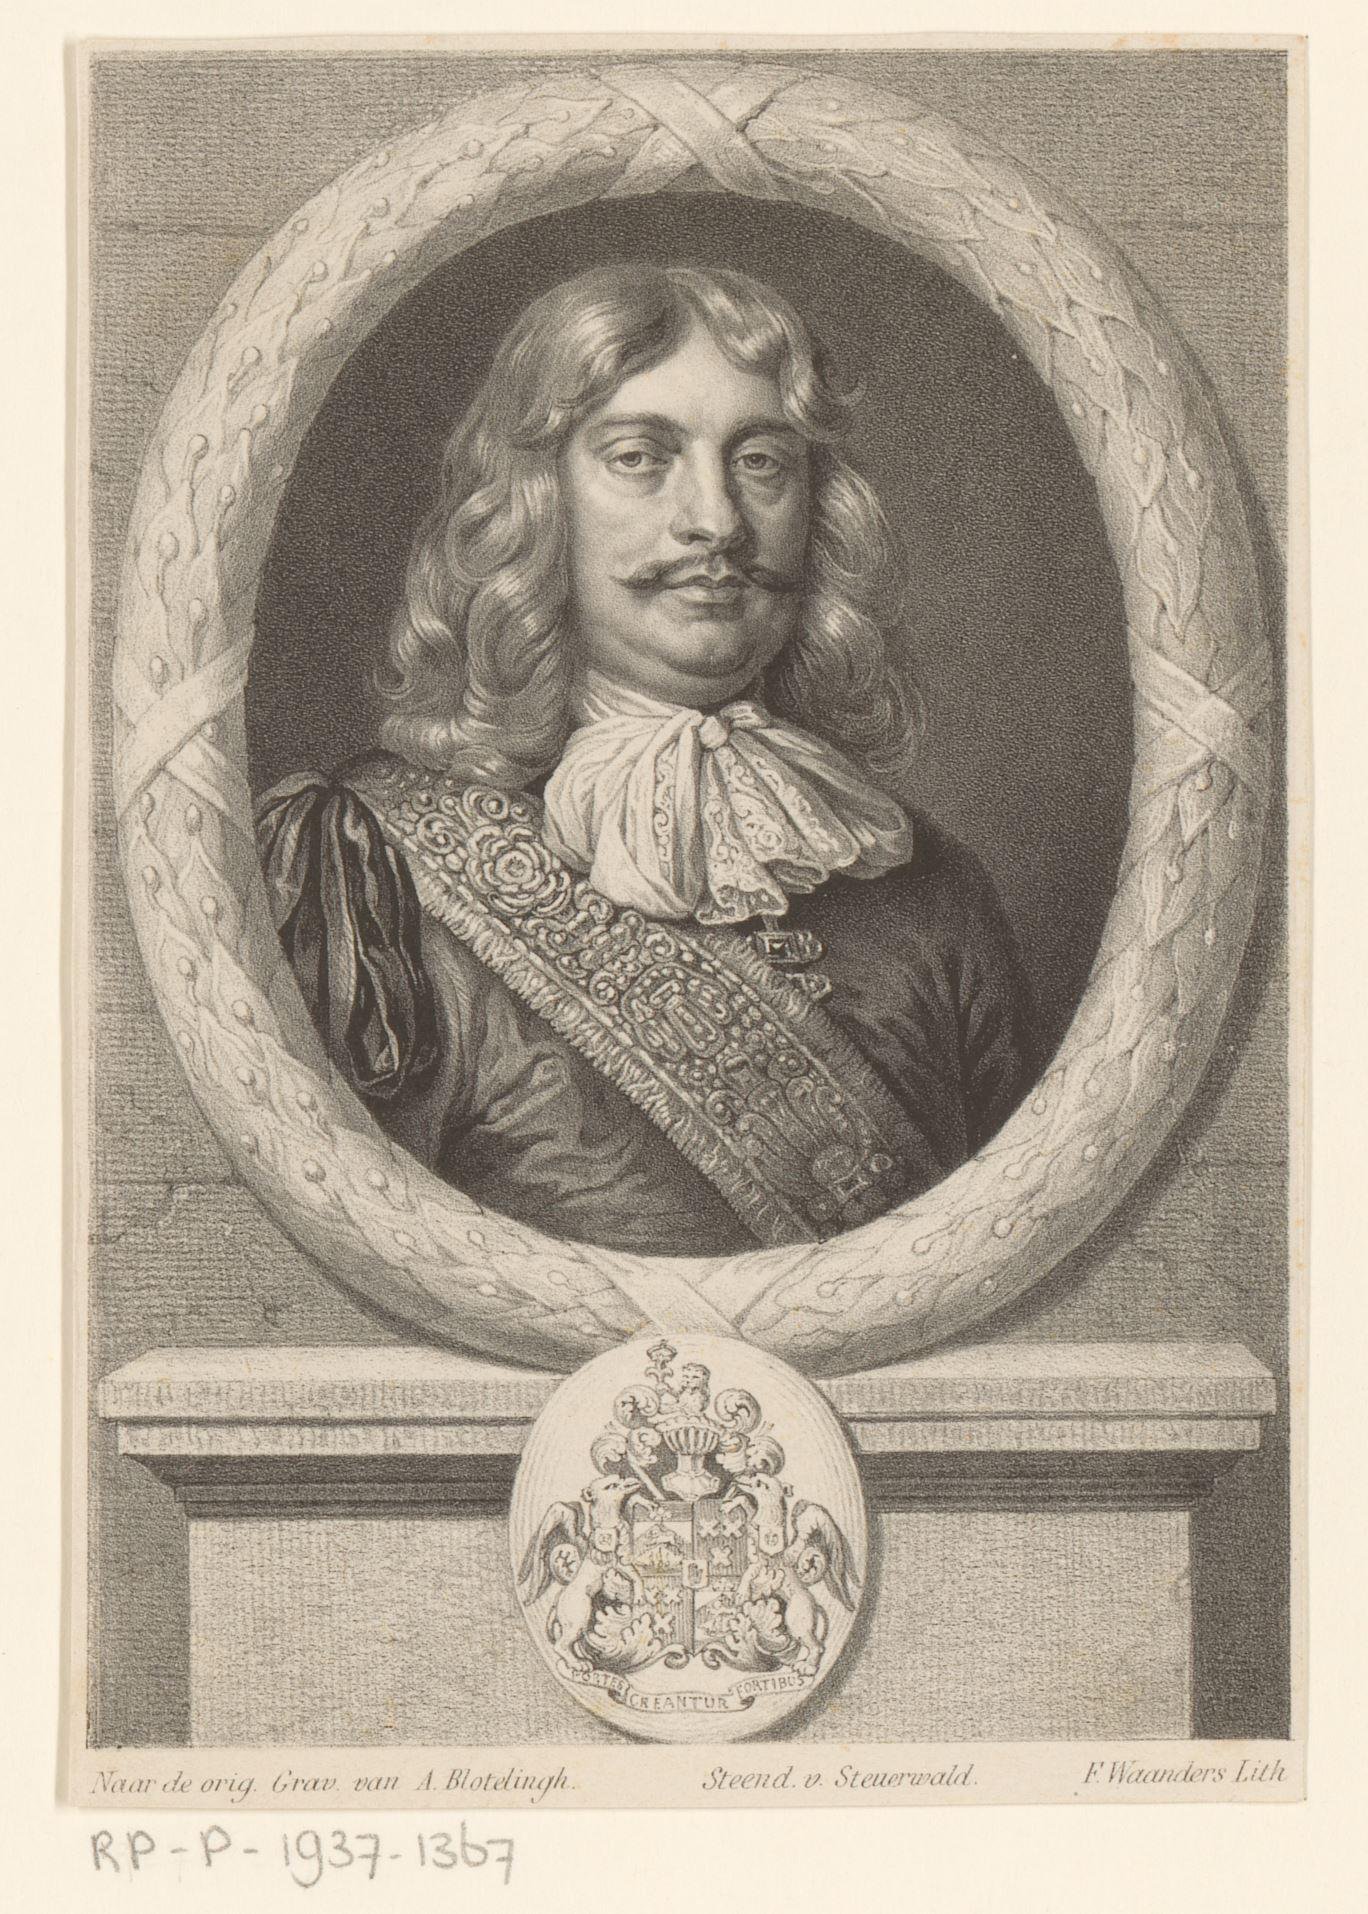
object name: print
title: Portret van Cornelis Tromp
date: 1833-1863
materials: paper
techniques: lithograph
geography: the hague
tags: amsterdam, cornelis tromp, historical persons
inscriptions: collector's mark: Lugt 2228